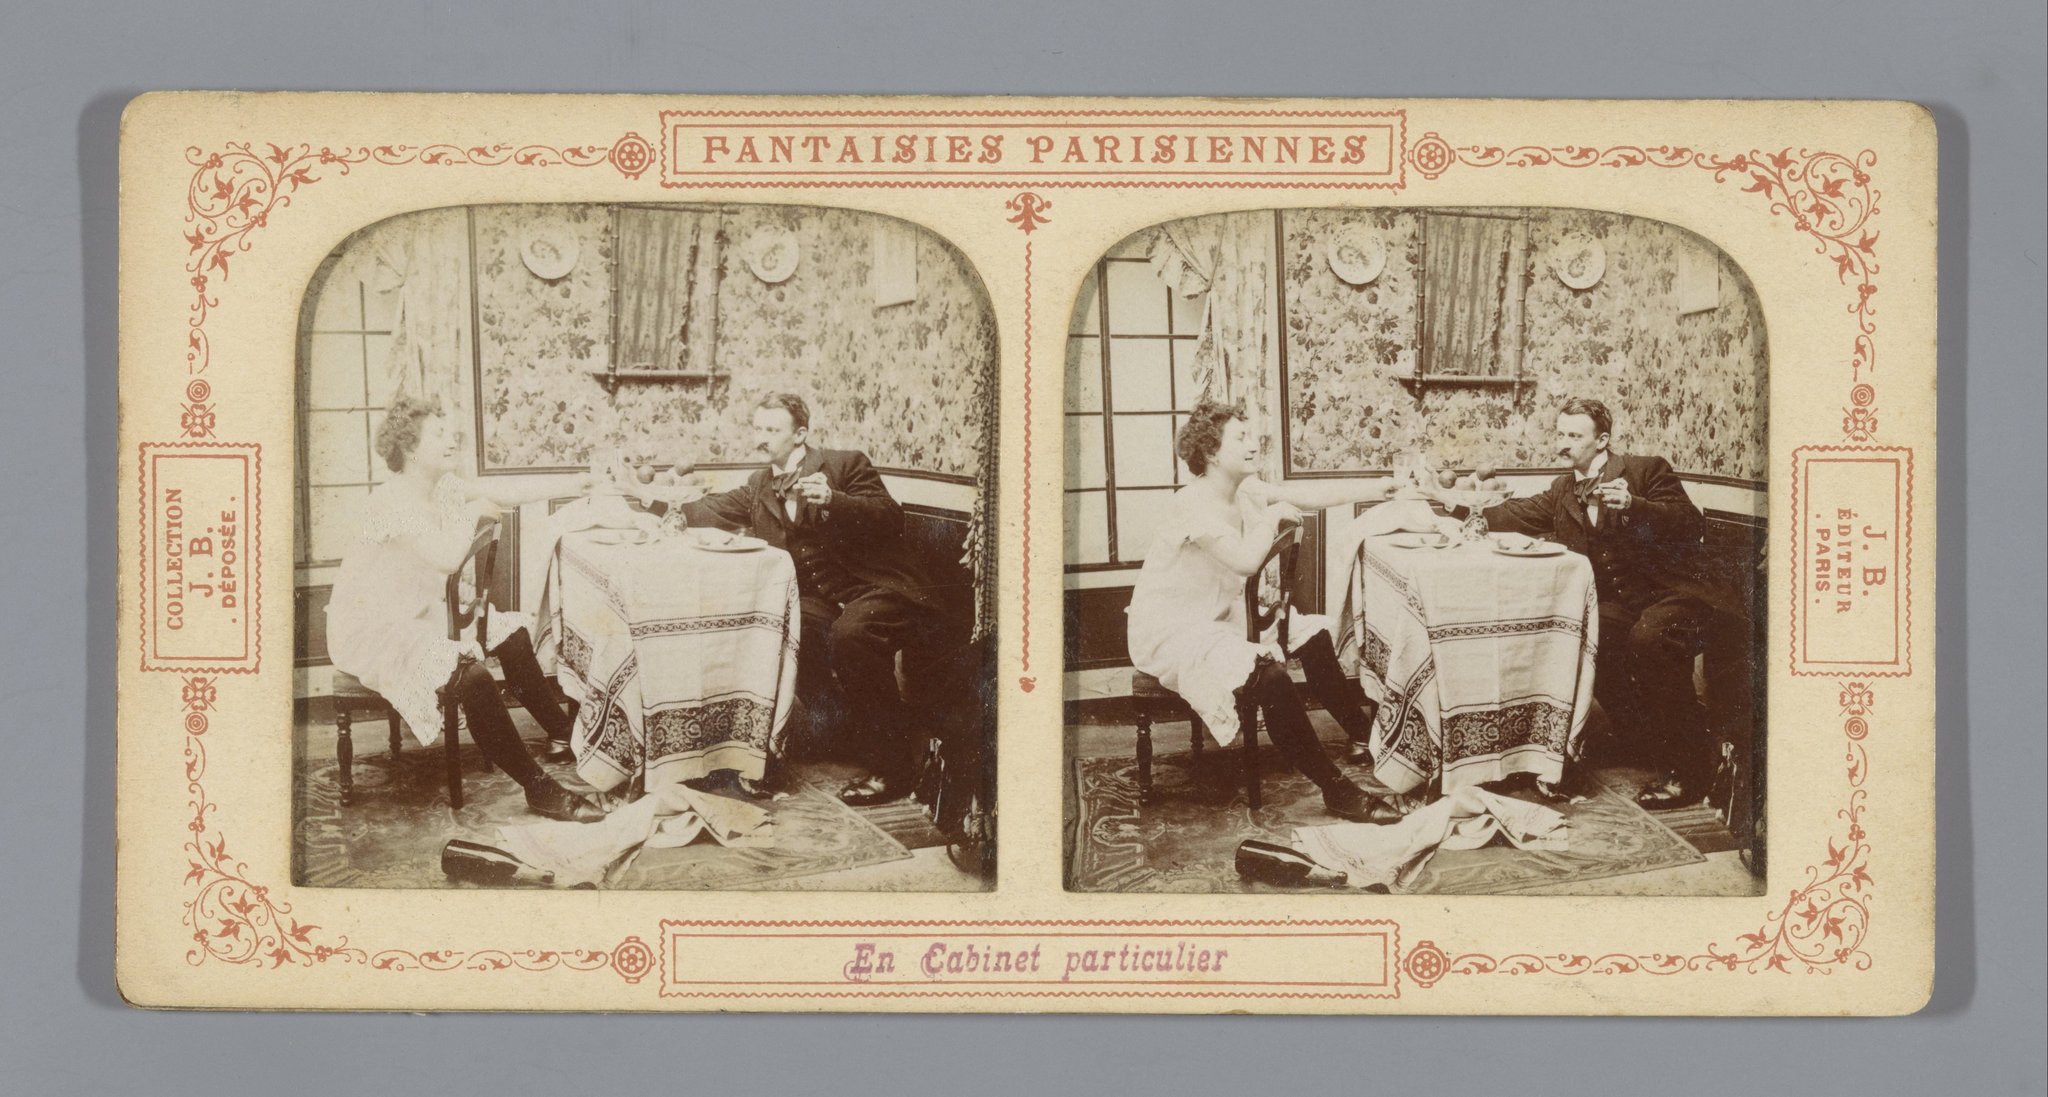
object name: tissue stereograph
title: Fantaisies Parisiennes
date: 1855-1875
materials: cardboard, paper, photographic support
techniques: albumen print, hand coloring, perforating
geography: france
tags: evening meal, dinner, supper, paris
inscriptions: inscription: ‘DÉPOSÉE’, number: ‘3457’